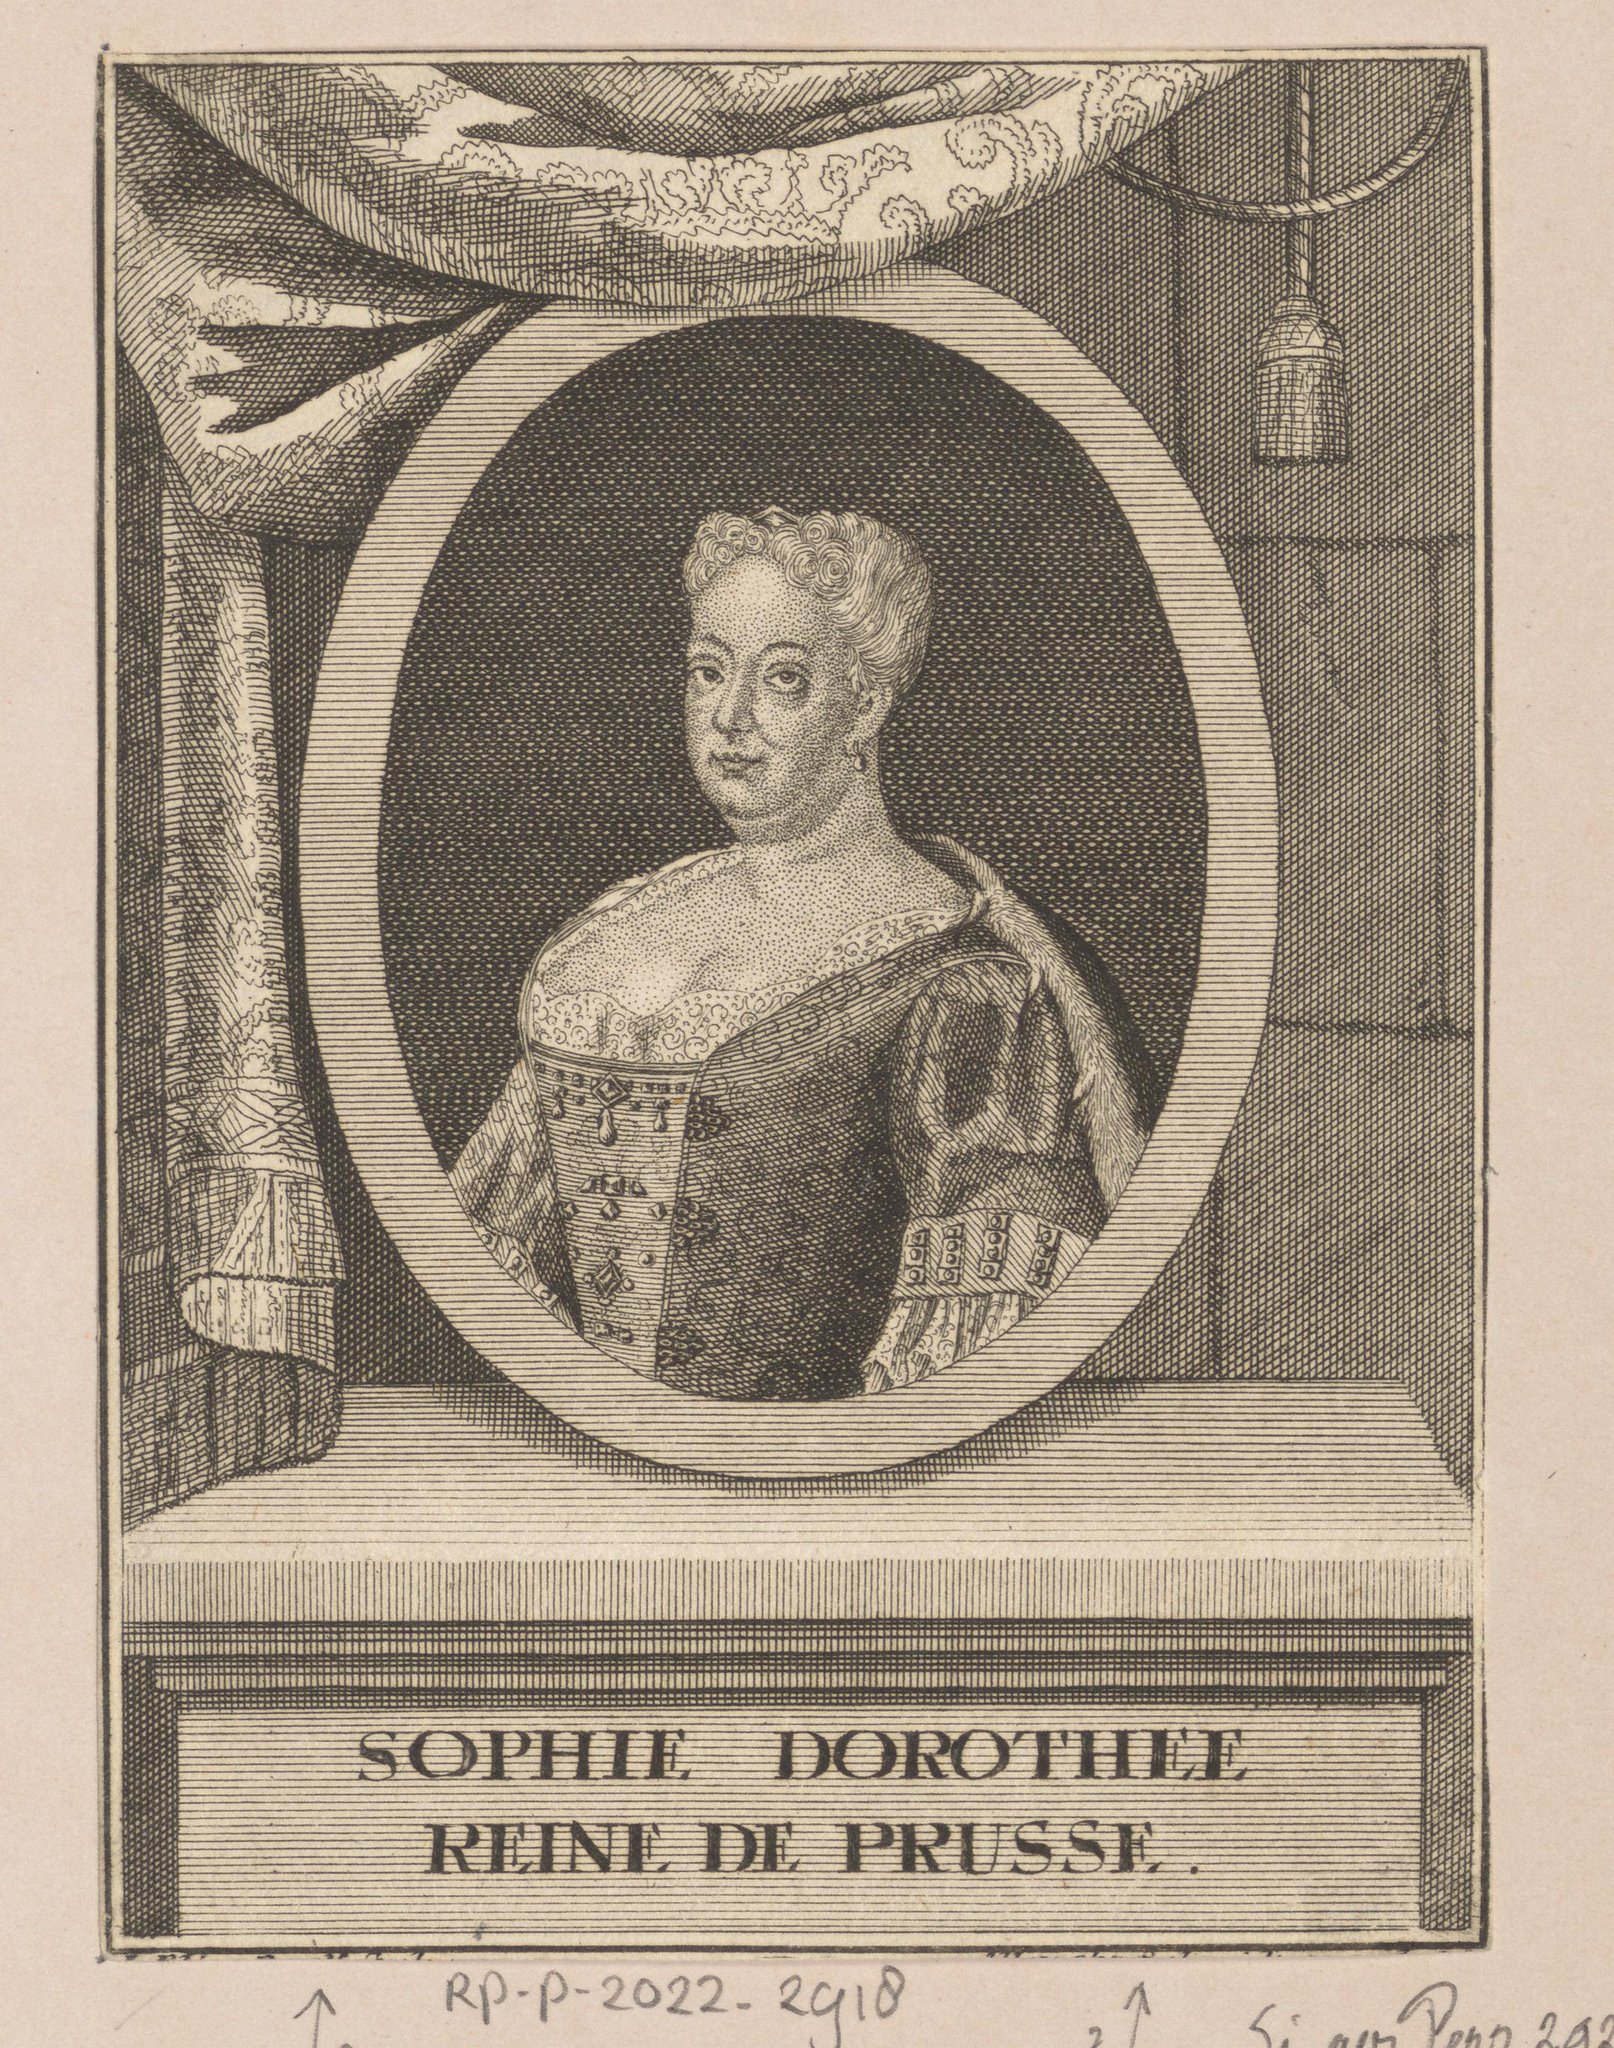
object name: print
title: Portret van Sophia Dorothea van Hannover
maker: Anonymous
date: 1713-1740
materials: paper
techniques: etching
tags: berlin, historical persons - bb - woman, queen, empress, etc. (wife of a ruler)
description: Met eenregelig onderschrift in het Frans.